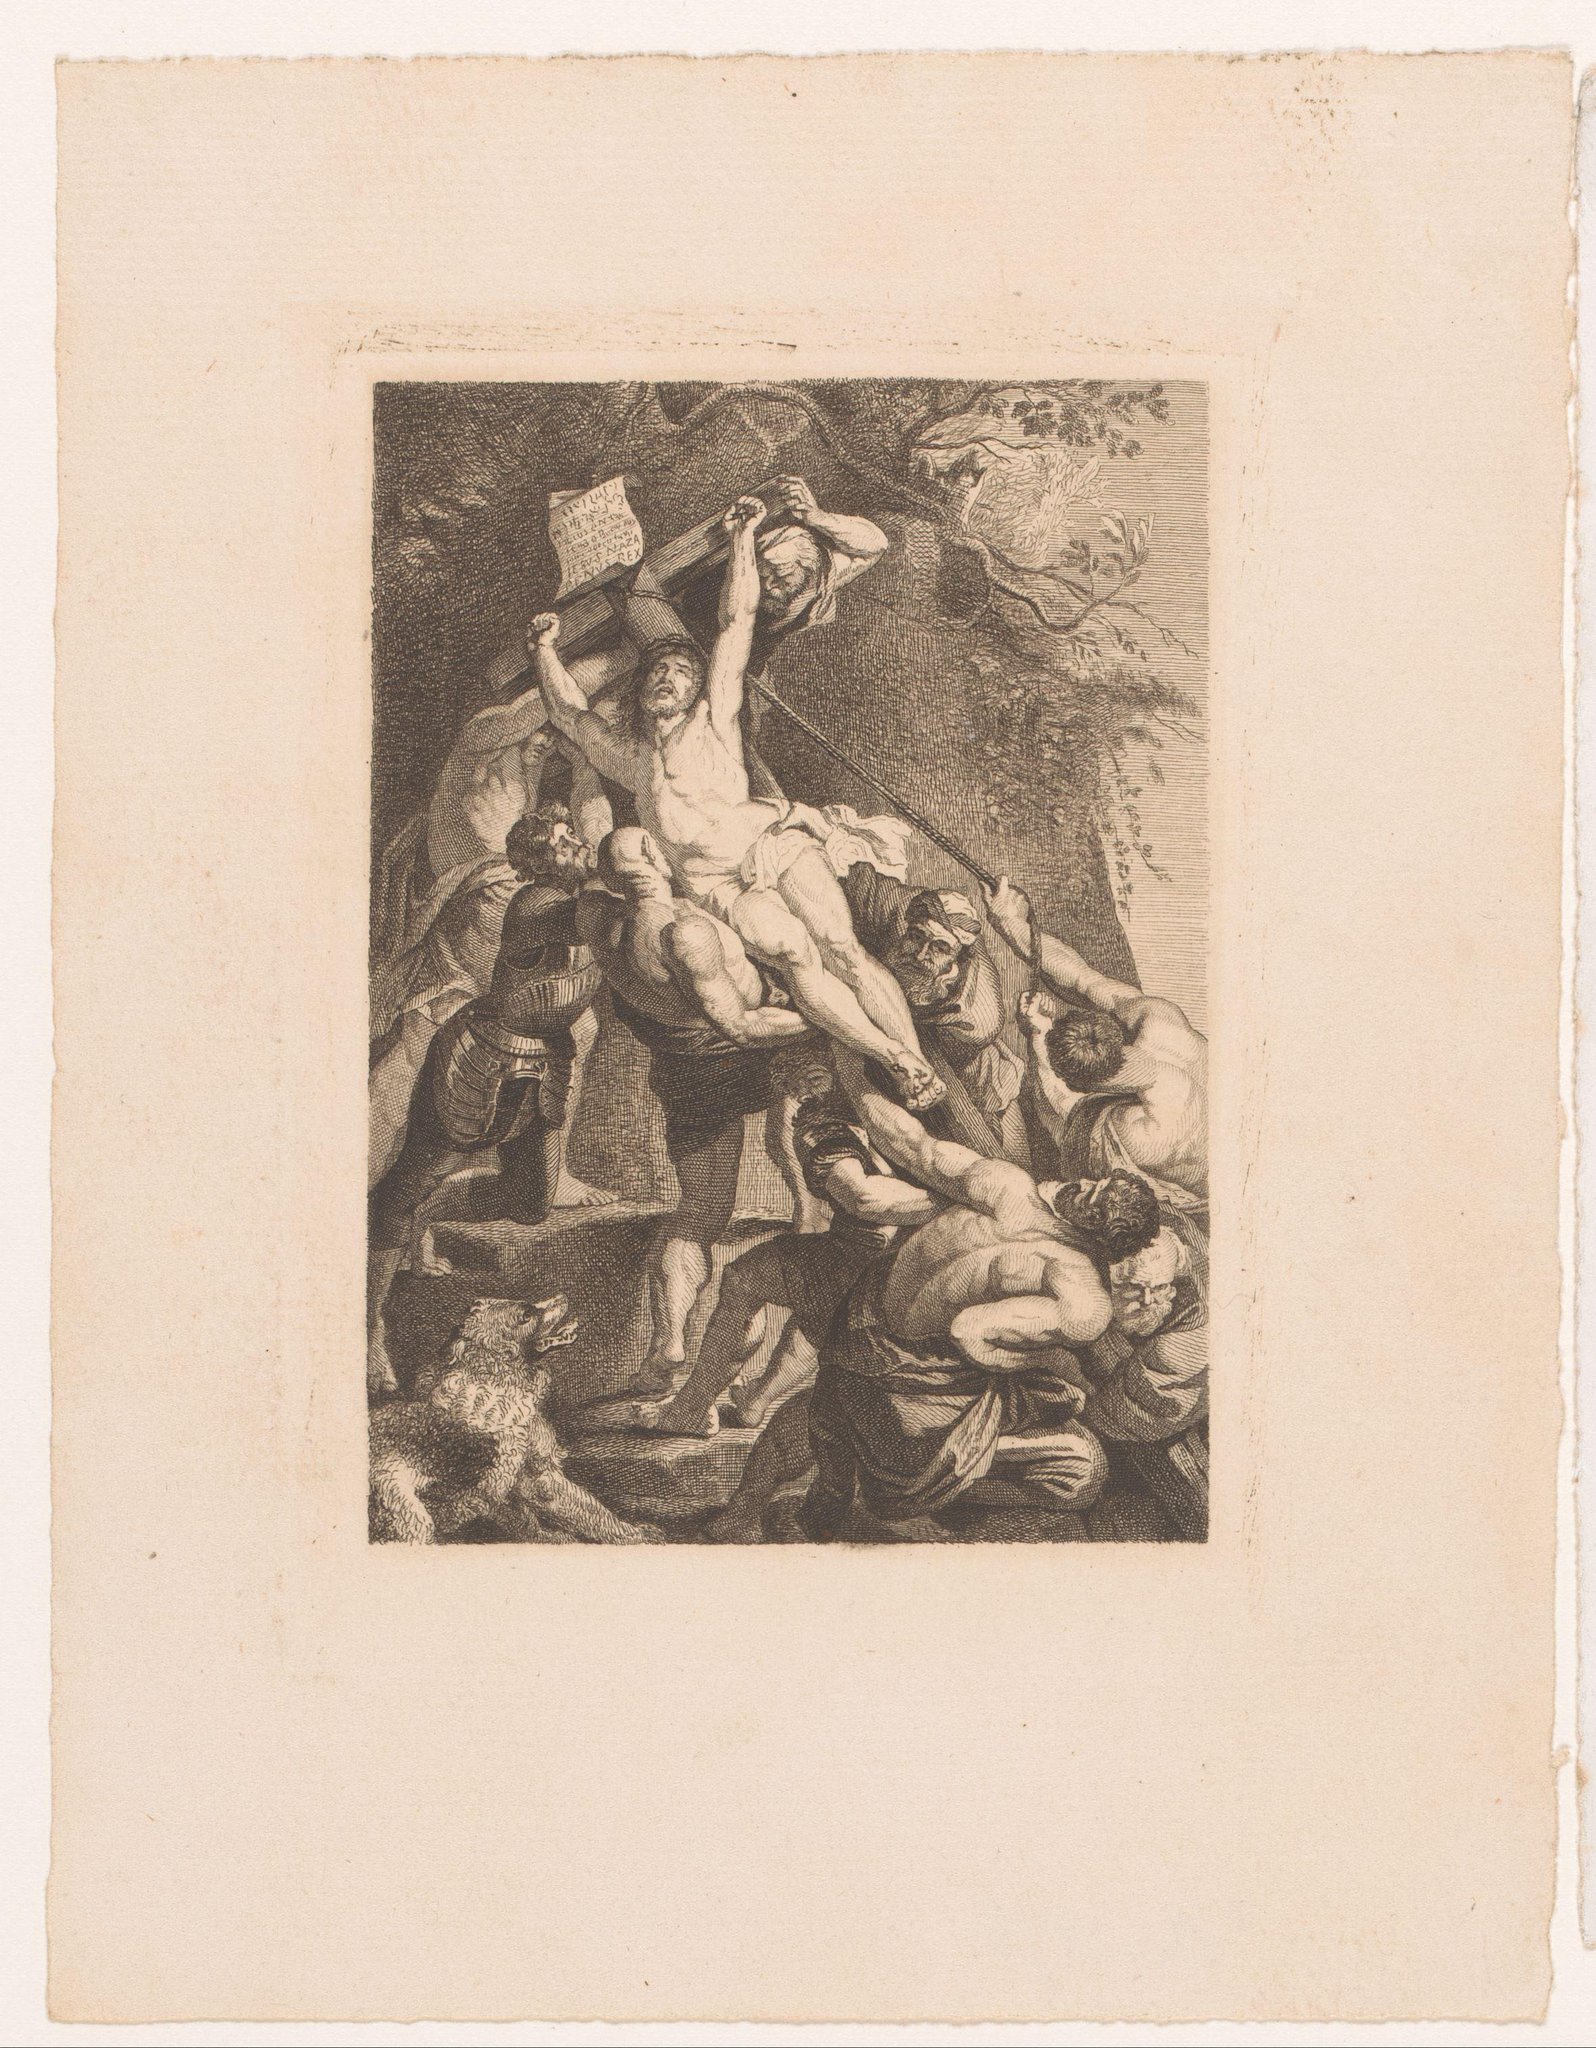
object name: print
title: Kruisoprichting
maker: jean baptiste pierre michiels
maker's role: print maker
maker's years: 1821-1890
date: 1831-1890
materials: paper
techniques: etching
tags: raising of the cross to which christ is nailed already, the crucifixion of christ: christ's death on the cross; golgotha (matthew 27:45-58; mark 15:33-45; luke 23:44-52; john 19:25-38)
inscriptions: collector's mark: Lugt 2228